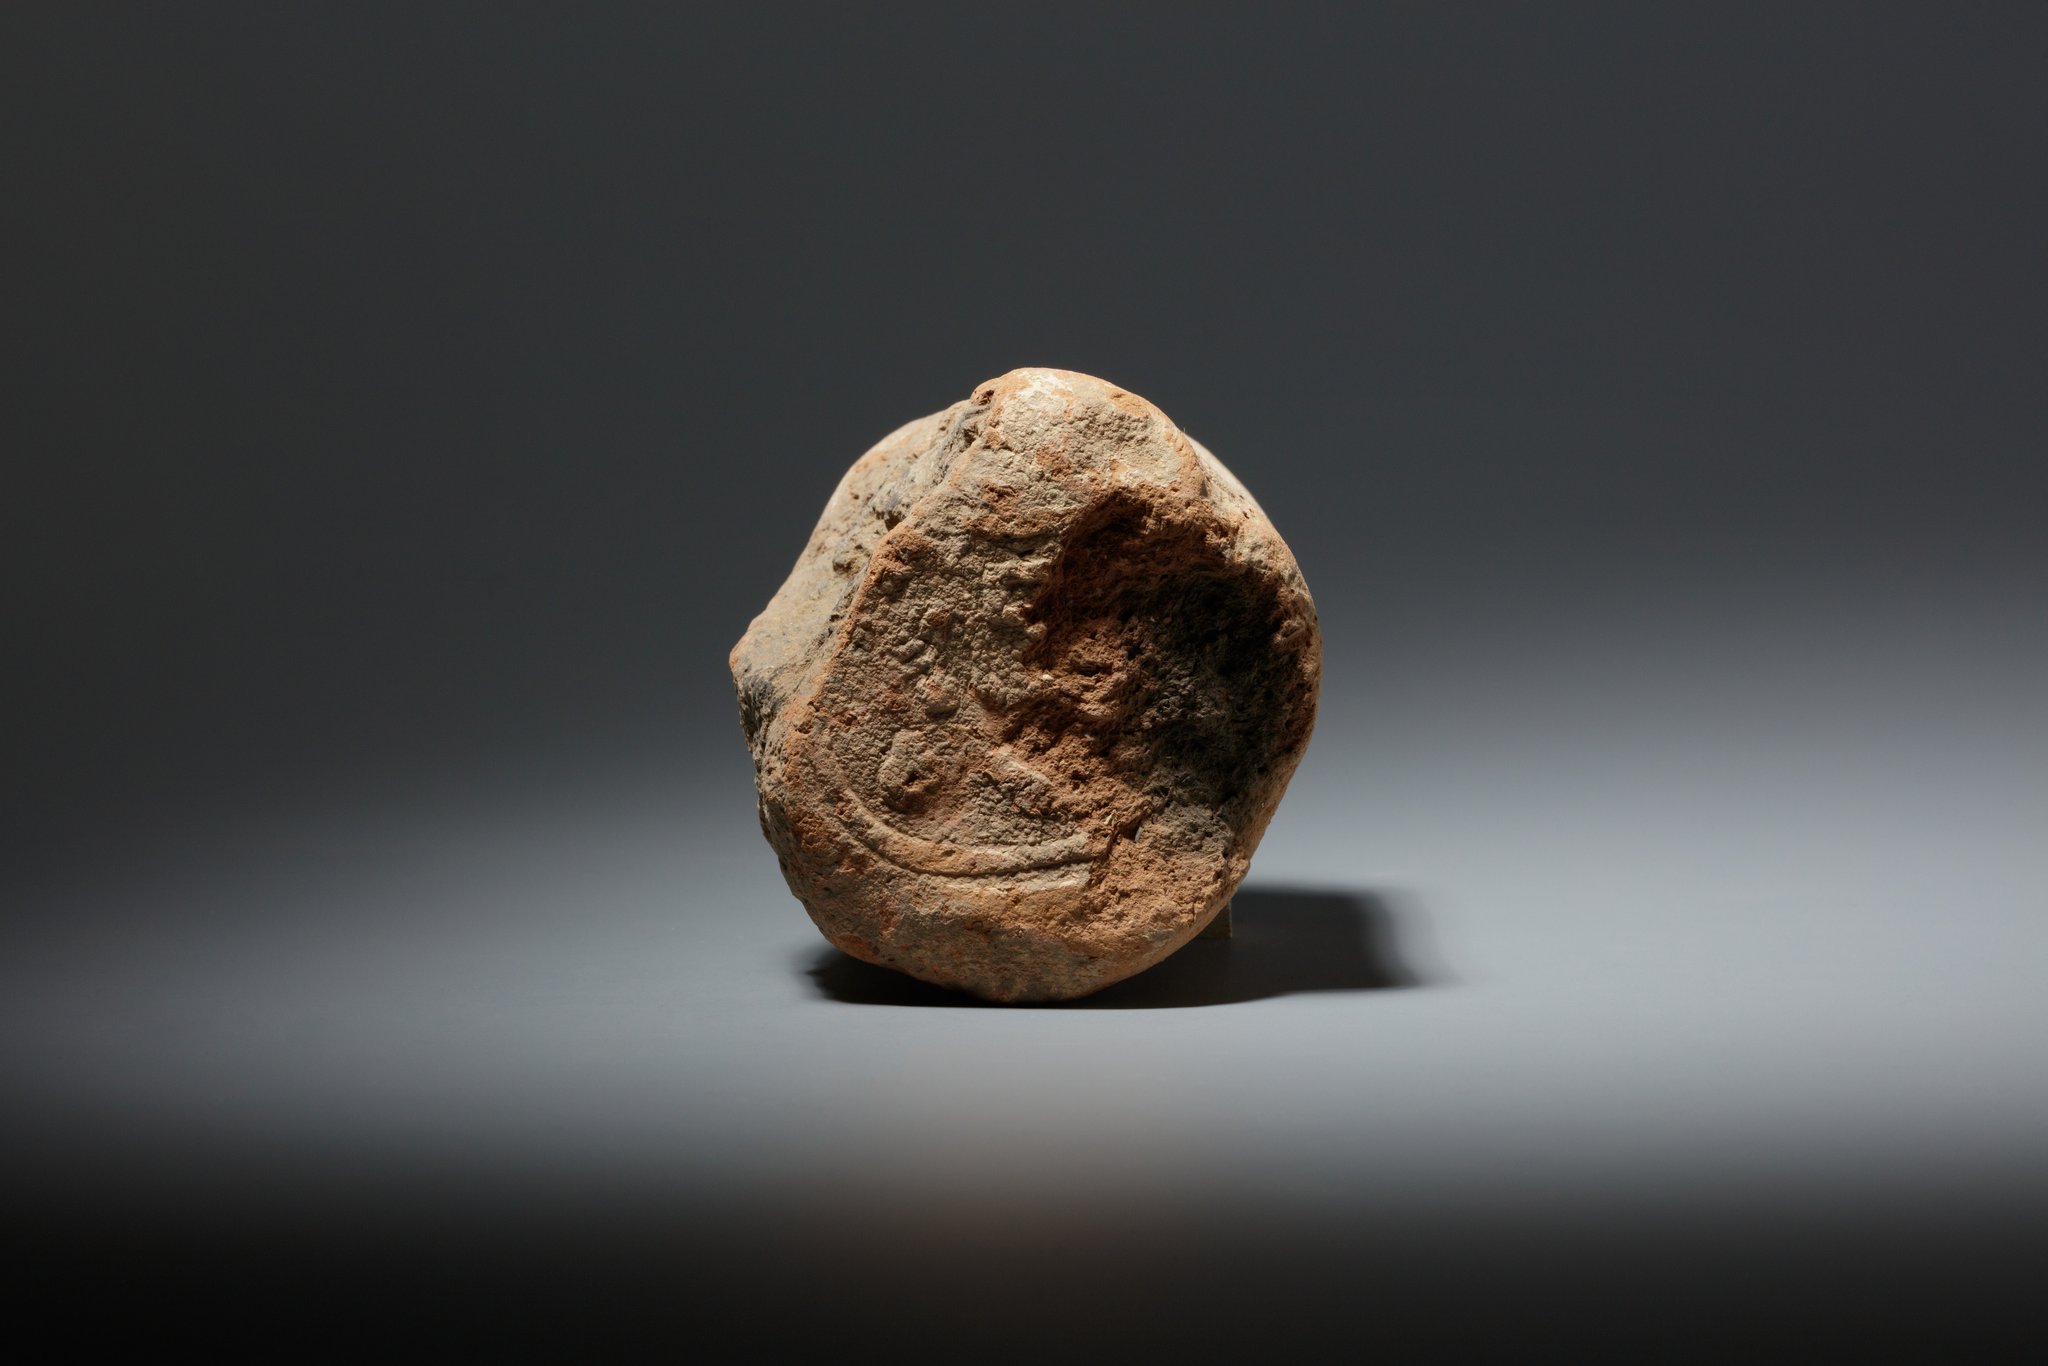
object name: cone, davy 578, senu, scribe, treasury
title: Funerary Cone of the Scribe of the Treasury Senu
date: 1550-1295 BCE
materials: pottery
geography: egypt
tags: hieroglyphs